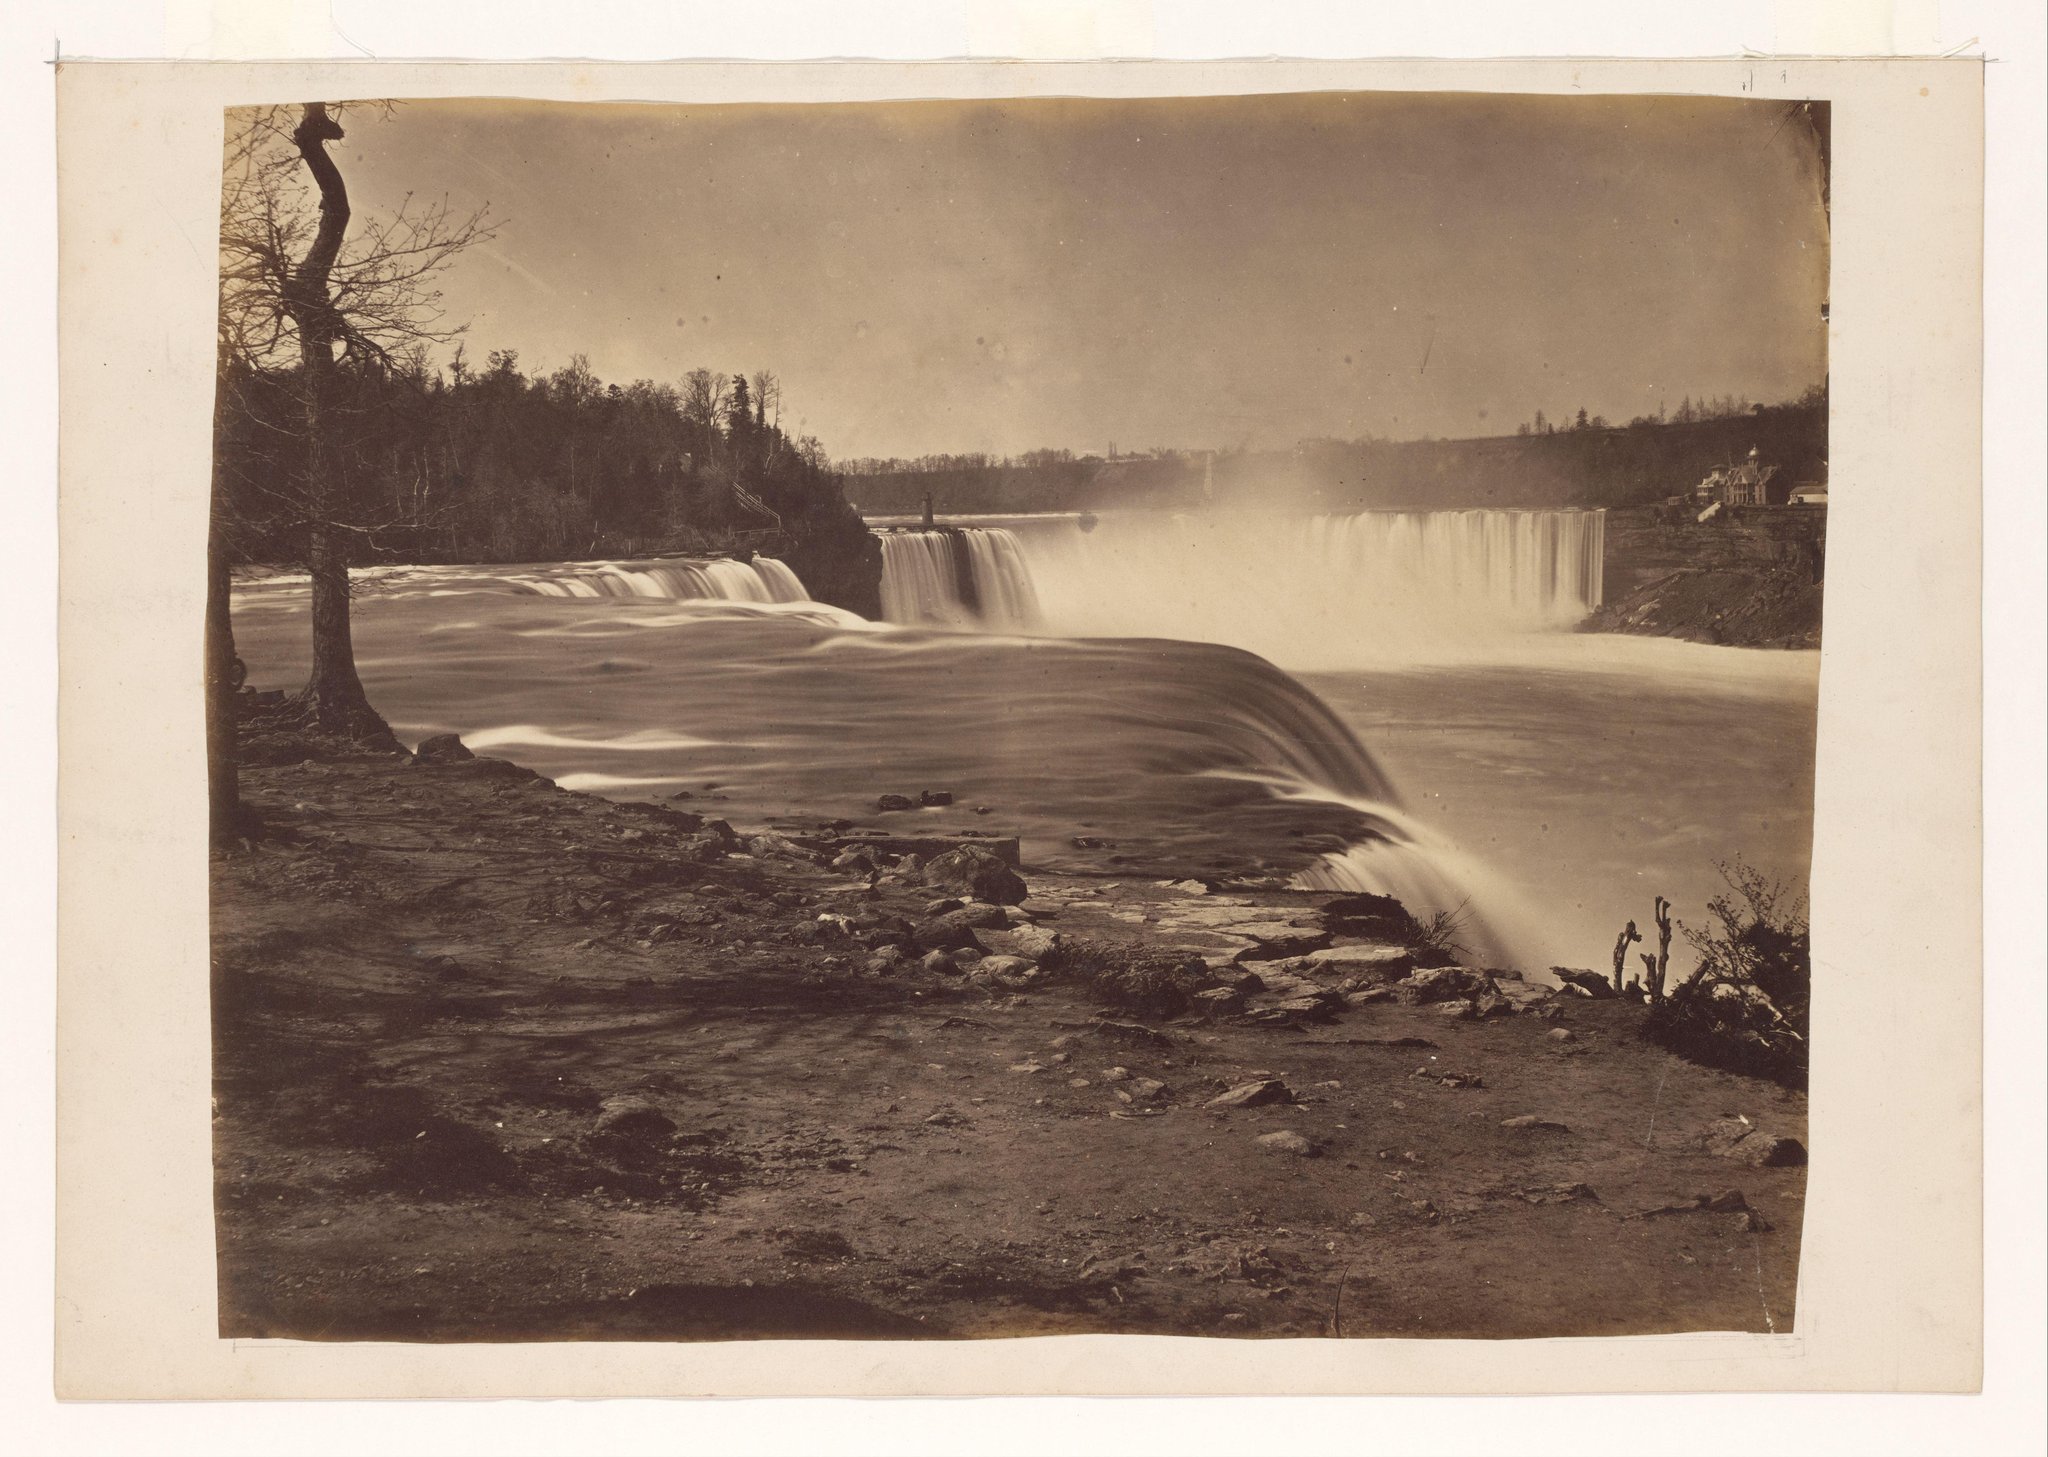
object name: photograph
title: Verenigde Staten, Niagara Falls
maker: Anonymous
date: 1860-1890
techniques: albumen print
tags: niagara falls